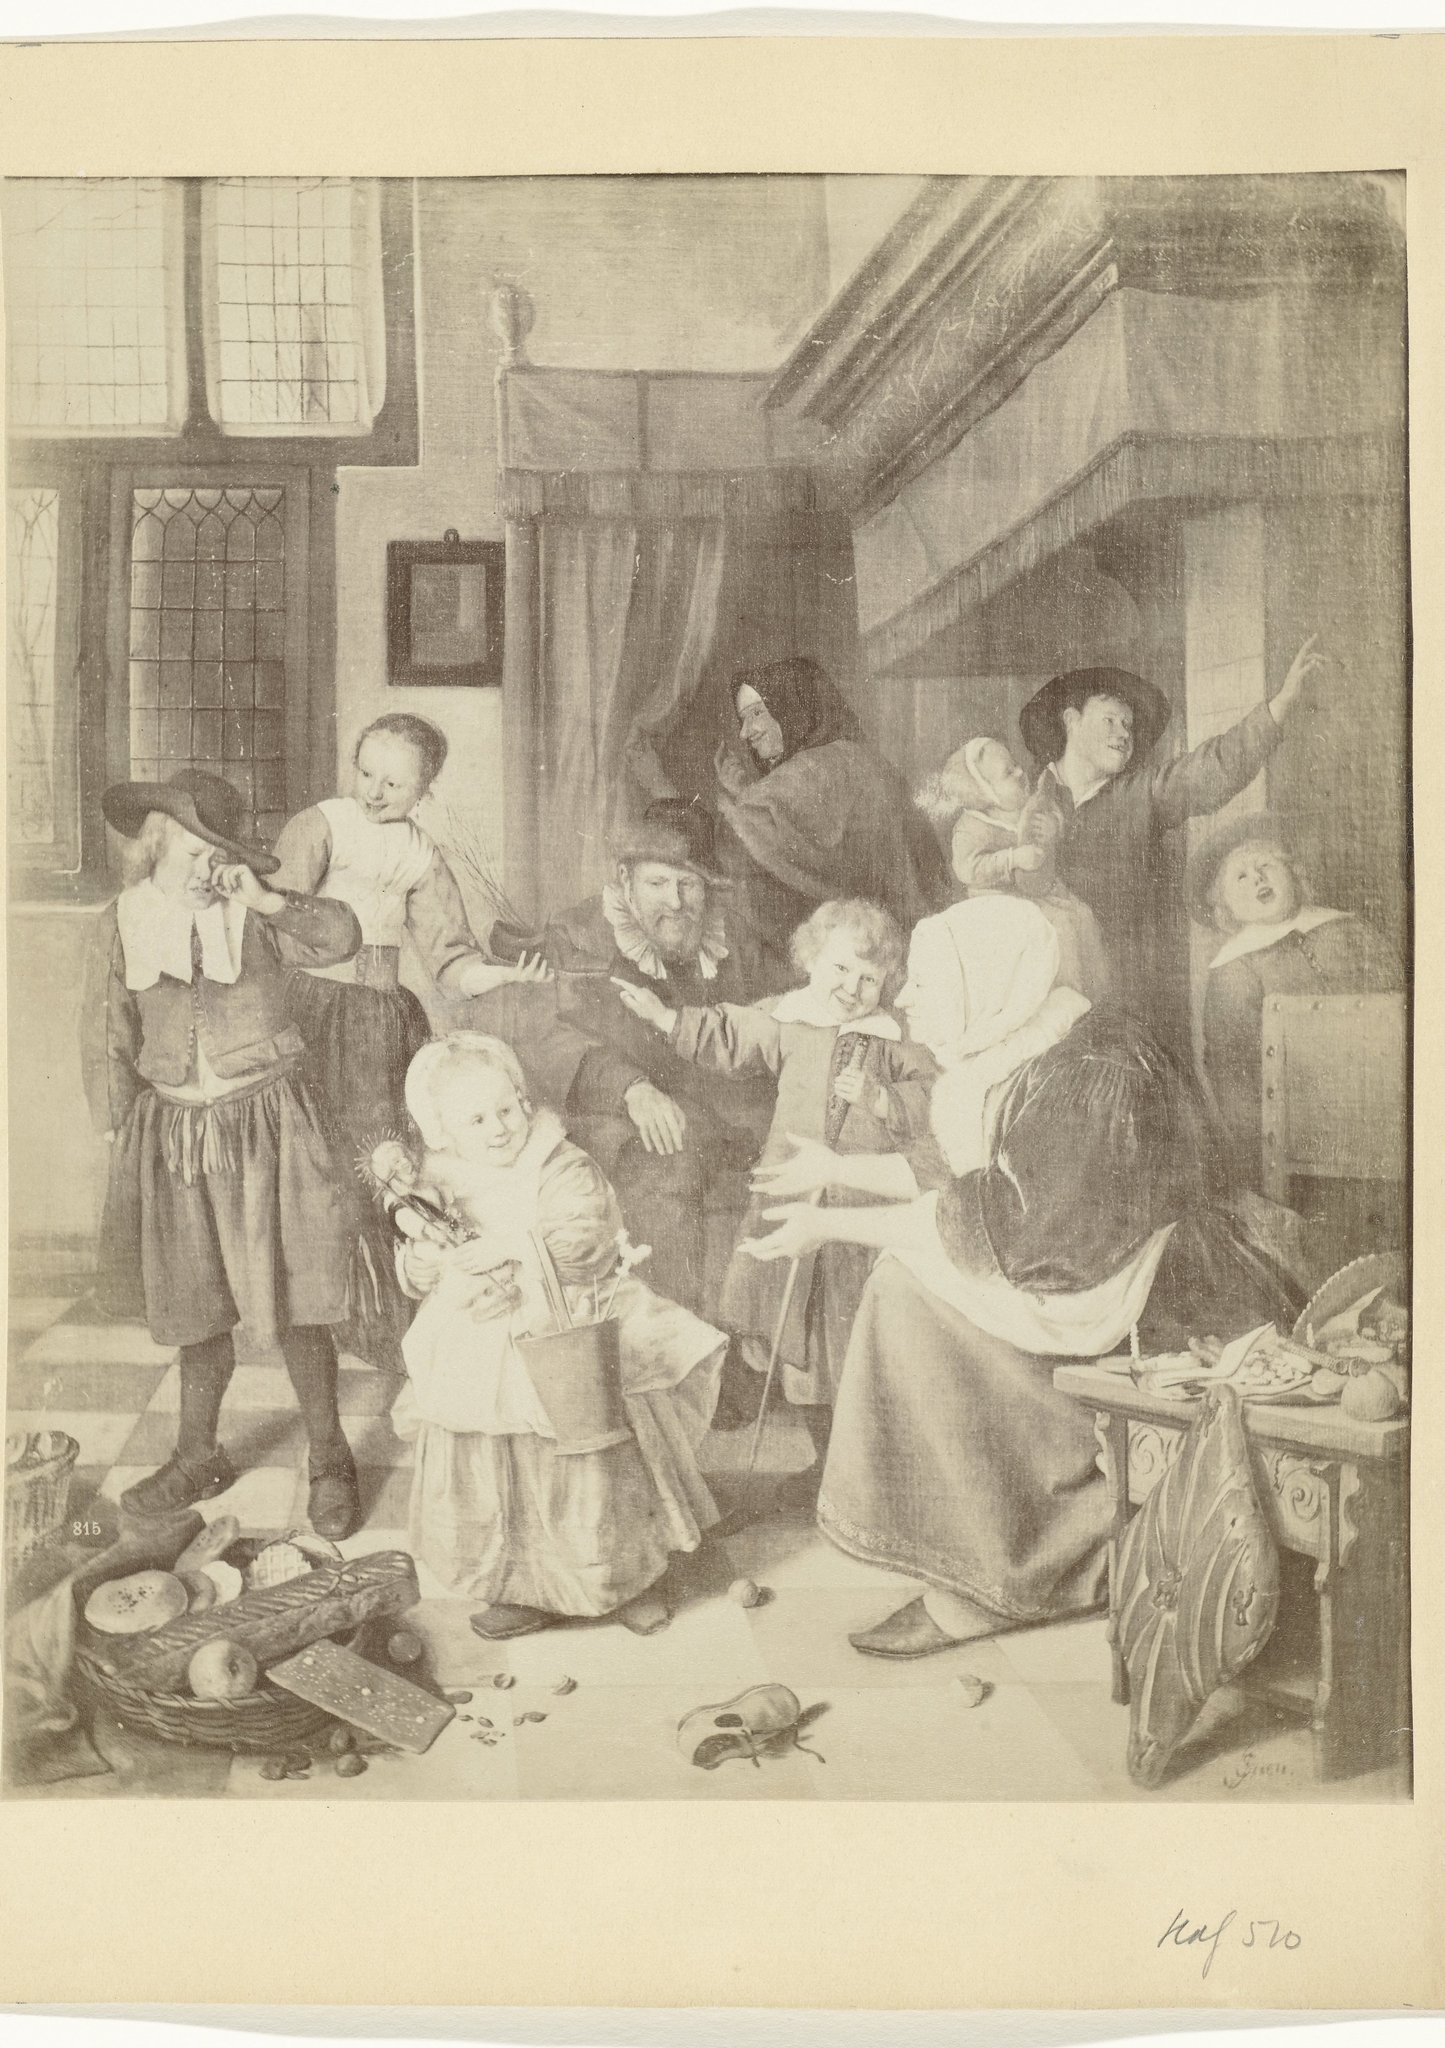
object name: photograph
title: Fotoreproductie van het schilderij Het Sint-Nicolaasfeest door Jan Steen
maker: Anonymous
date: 1867-1880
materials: cardboard, paper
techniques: albumen print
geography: paris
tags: festivities on st. nicholas (eve) (december 5), saint nicholas day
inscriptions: collector's mark: Lugt 2228, number: ‘815’, inscription: ‘Hdf 510’